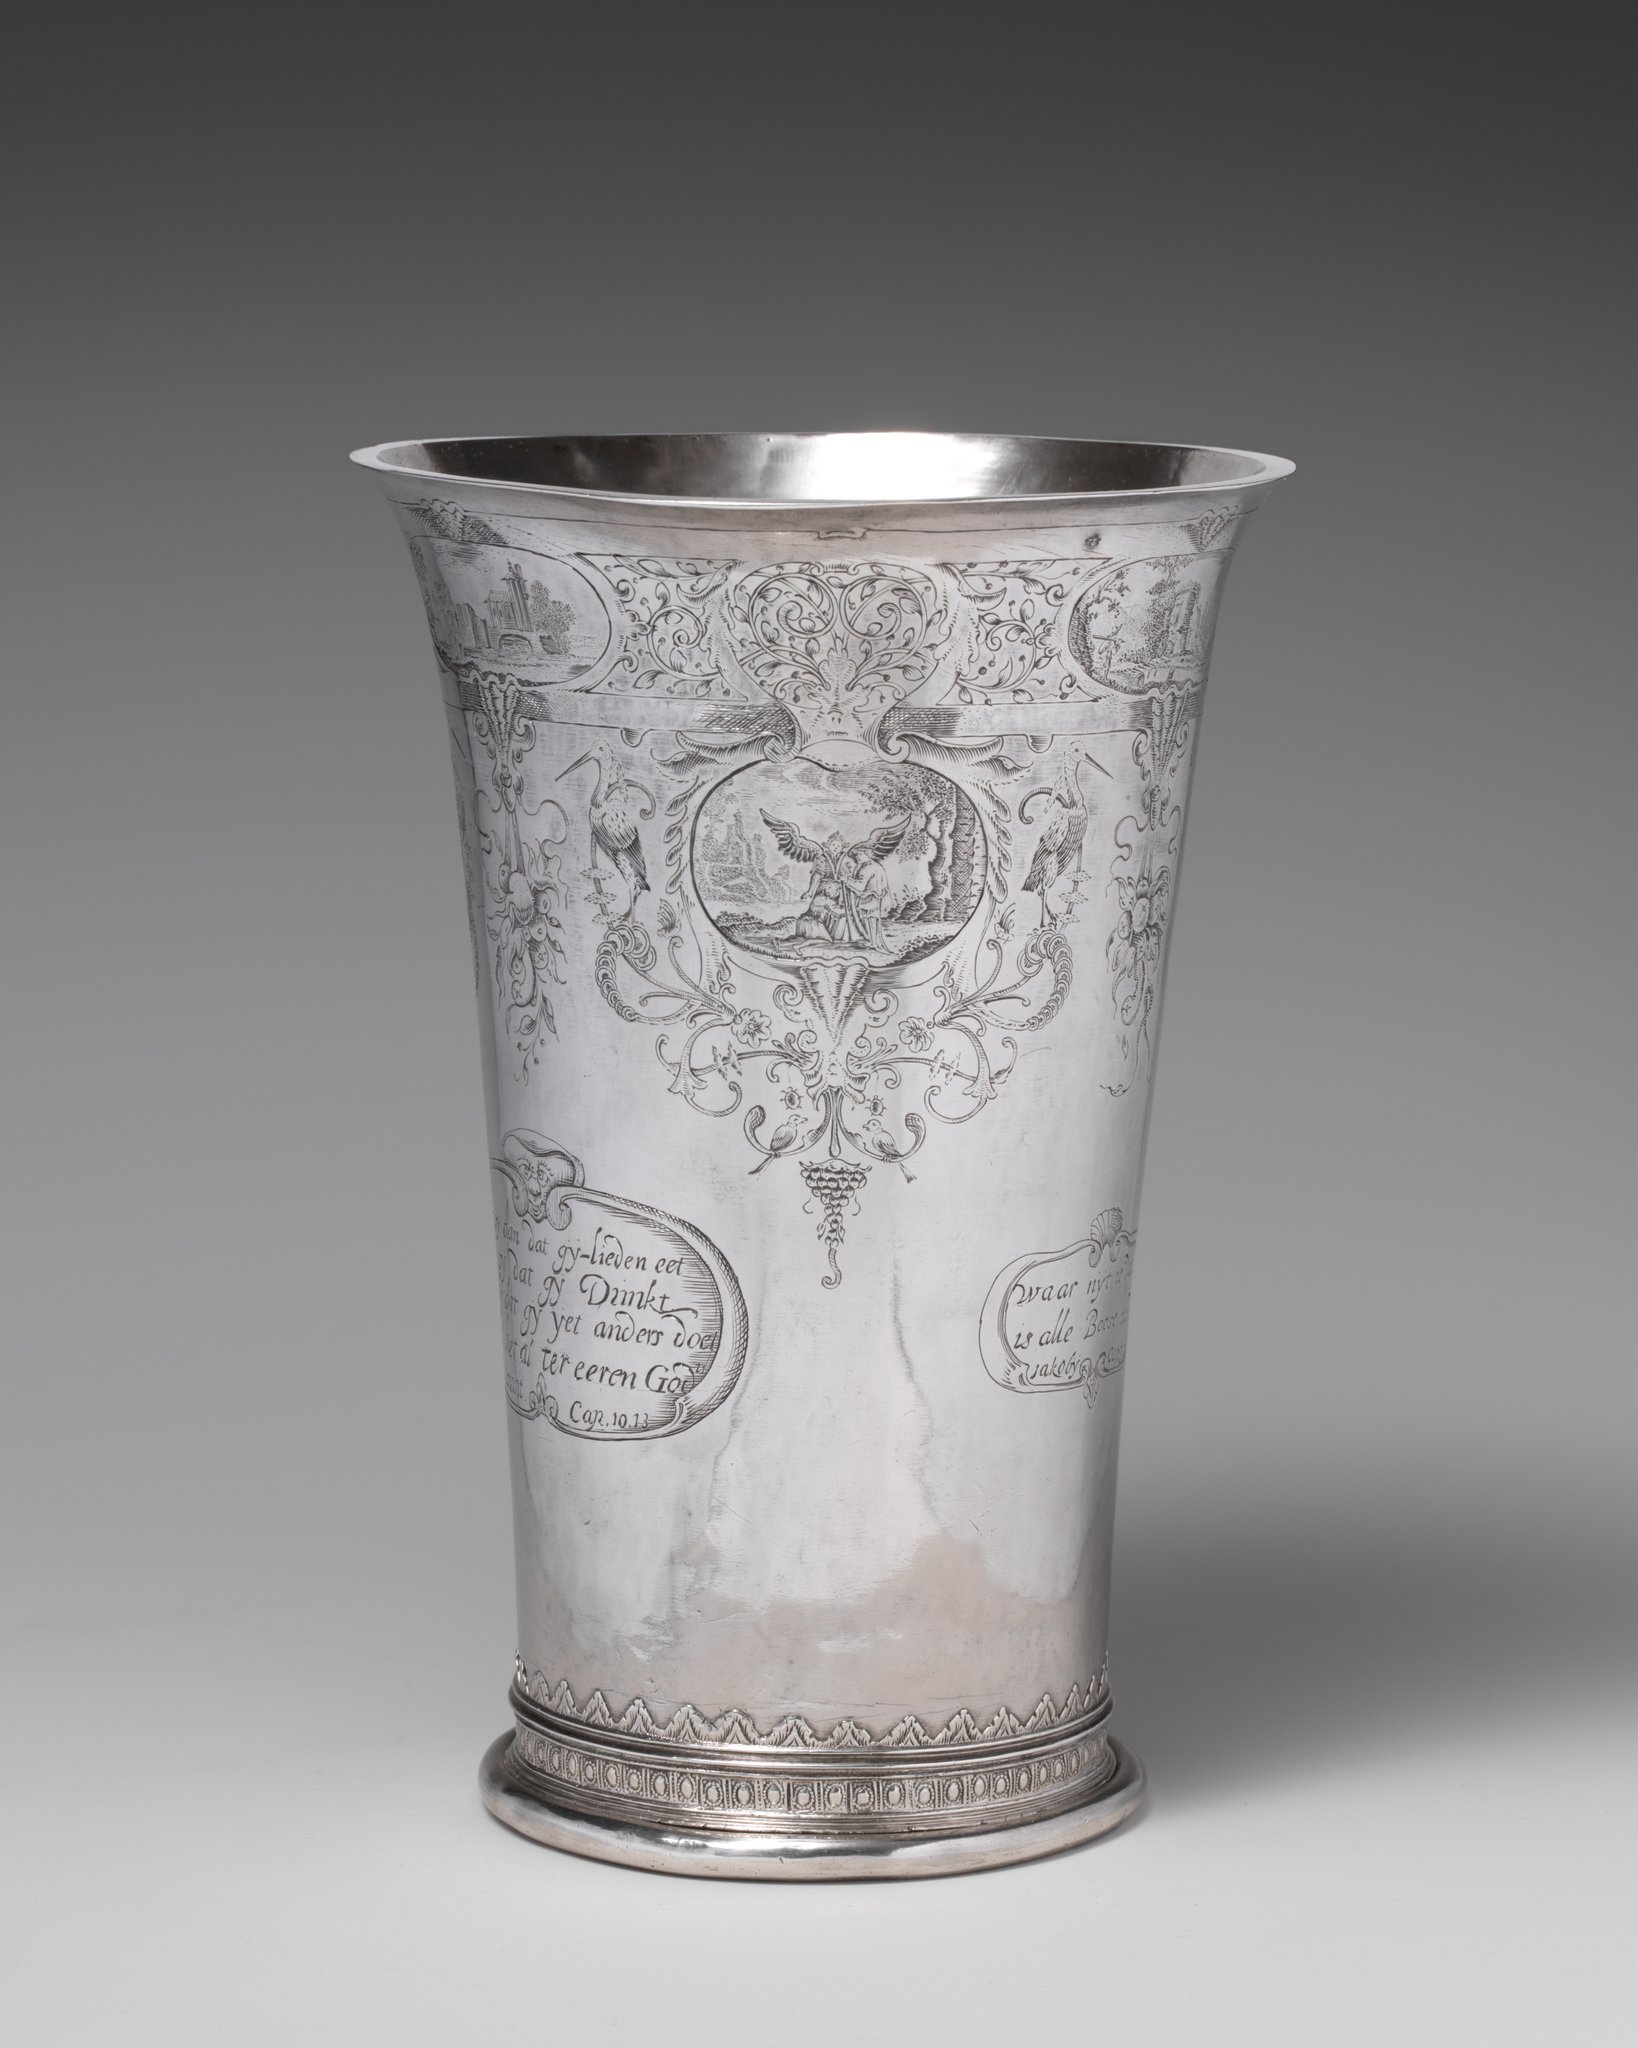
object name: beaker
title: Beaker with three scenes from the Story of Tobit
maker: jan van de velde ii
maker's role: artist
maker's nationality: dutch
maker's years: 1593-1641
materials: silver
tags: human figures,birds